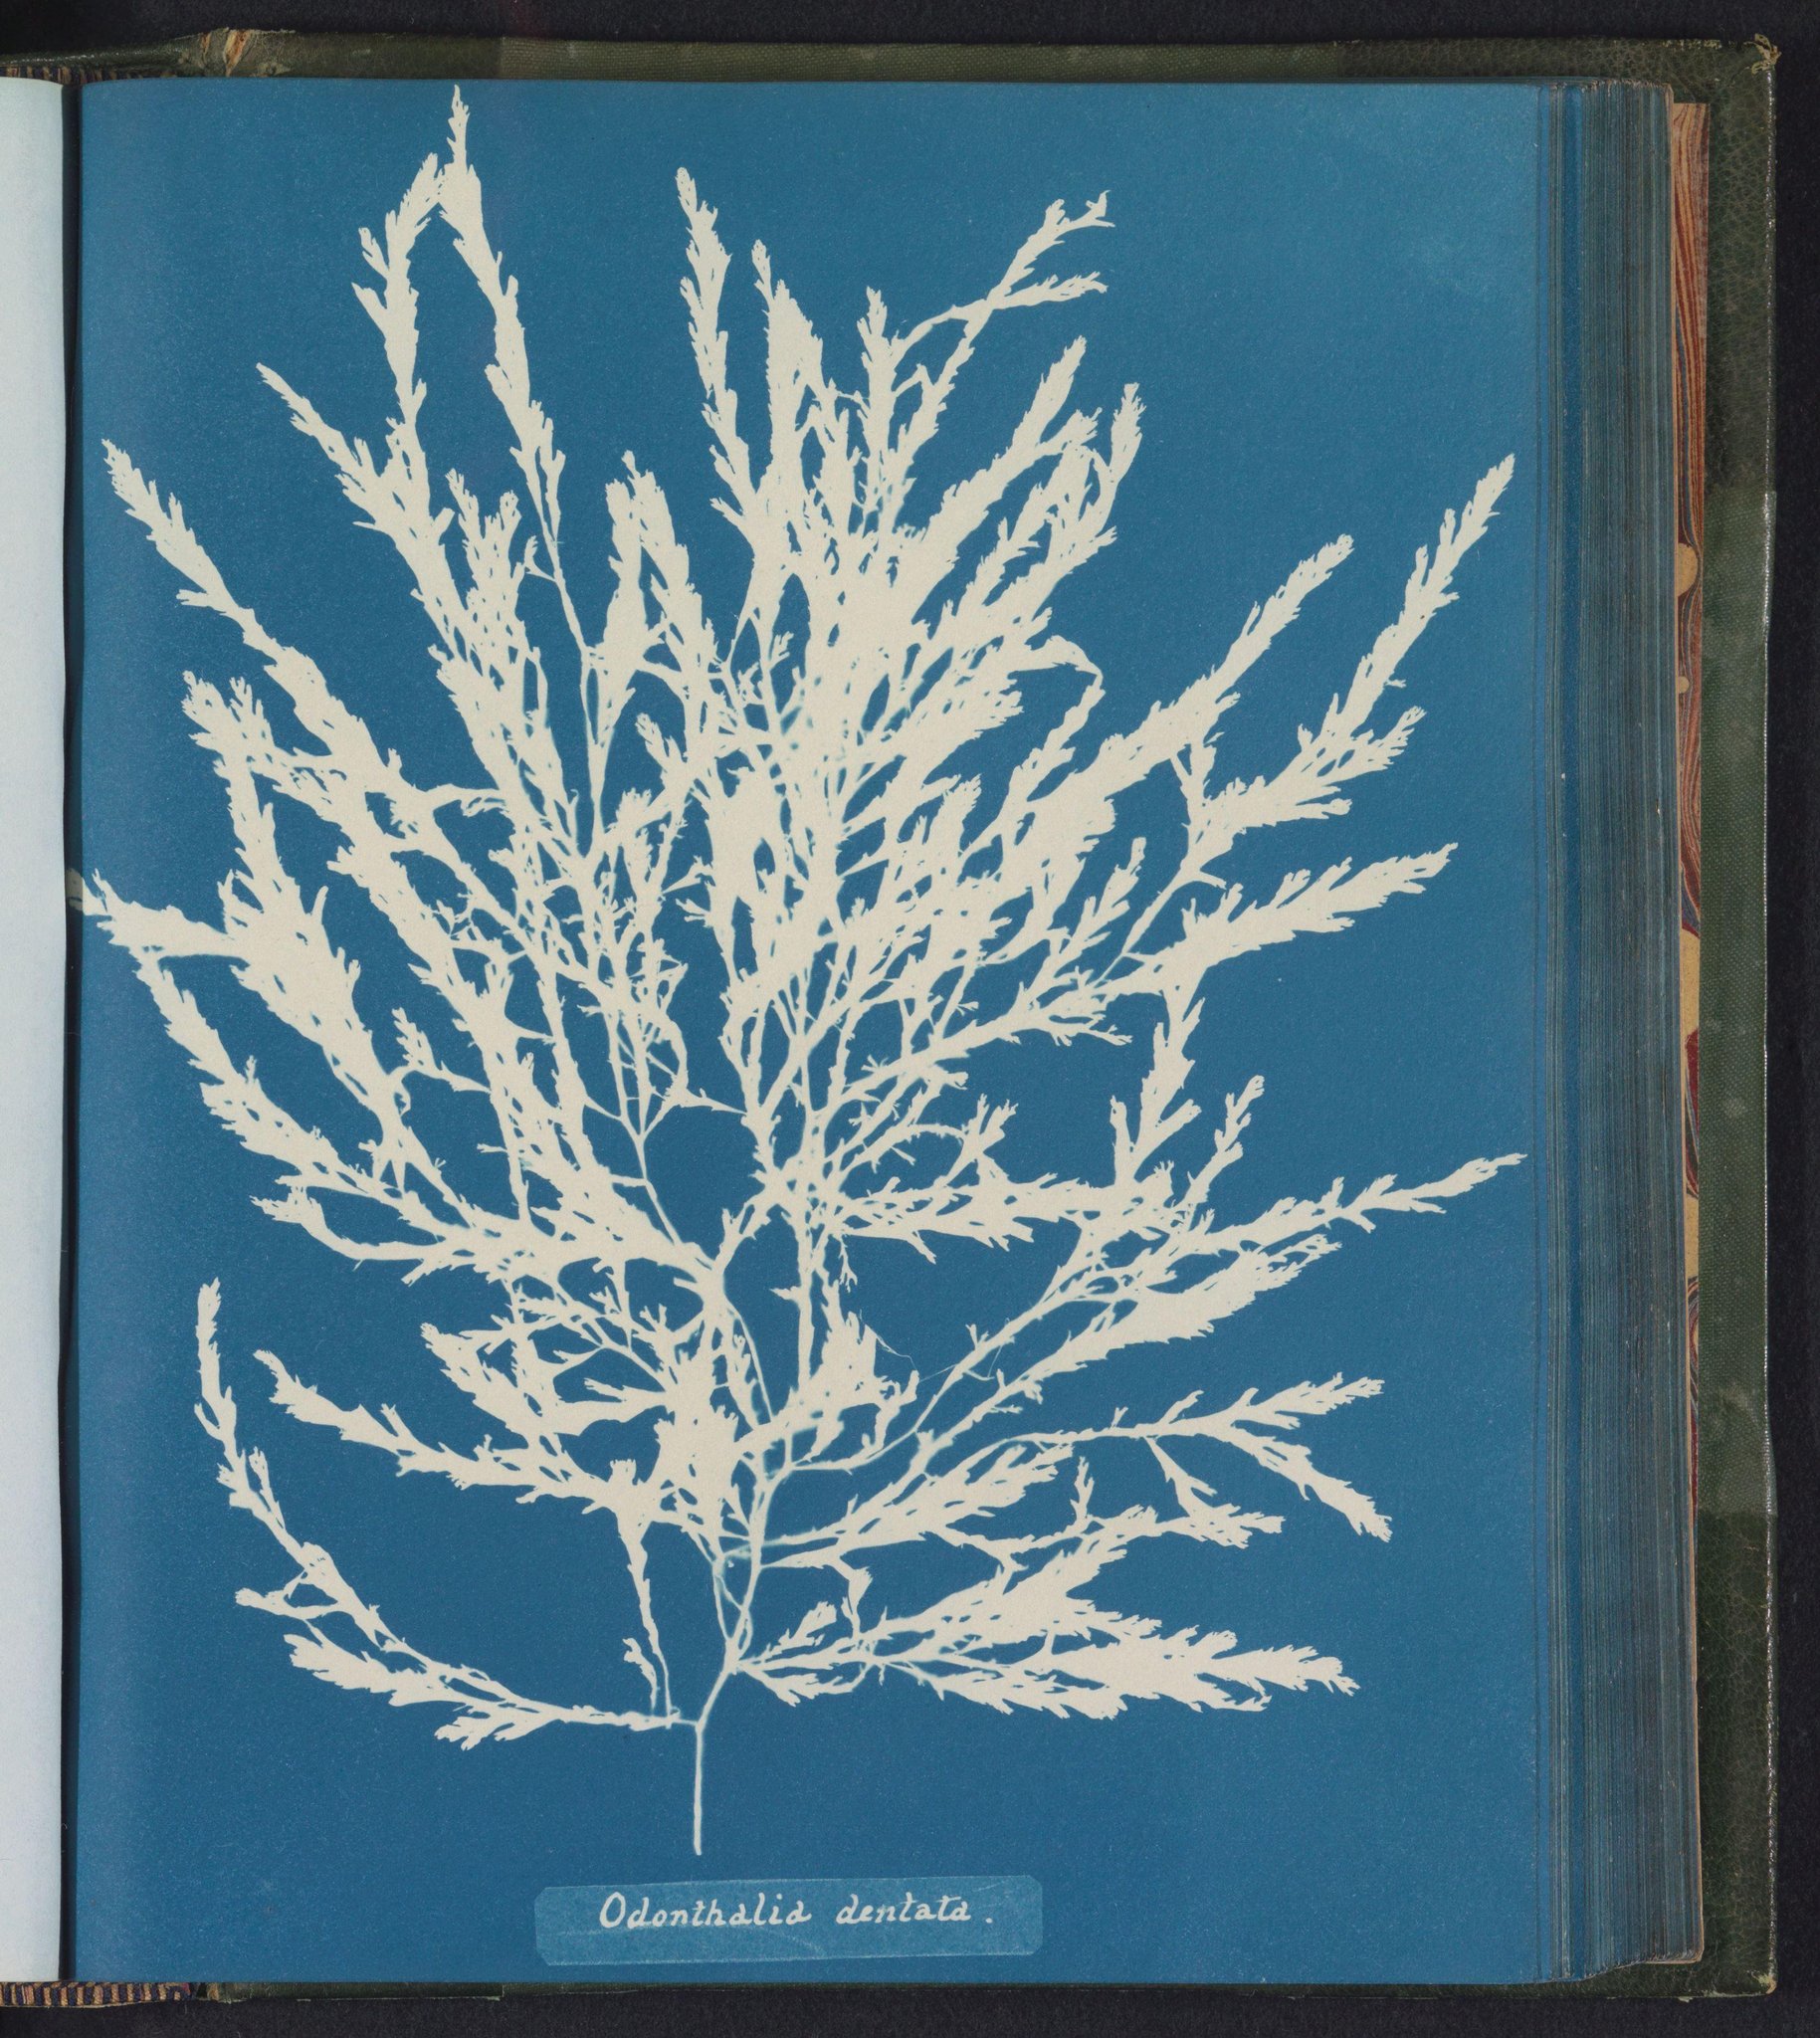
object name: page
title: Zeewier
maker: anna atkins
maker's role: fotograaf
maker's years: 1799-1871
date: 1843-1853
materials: photographic support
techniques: cyanotype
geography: united kingdom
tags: algae, seaweed